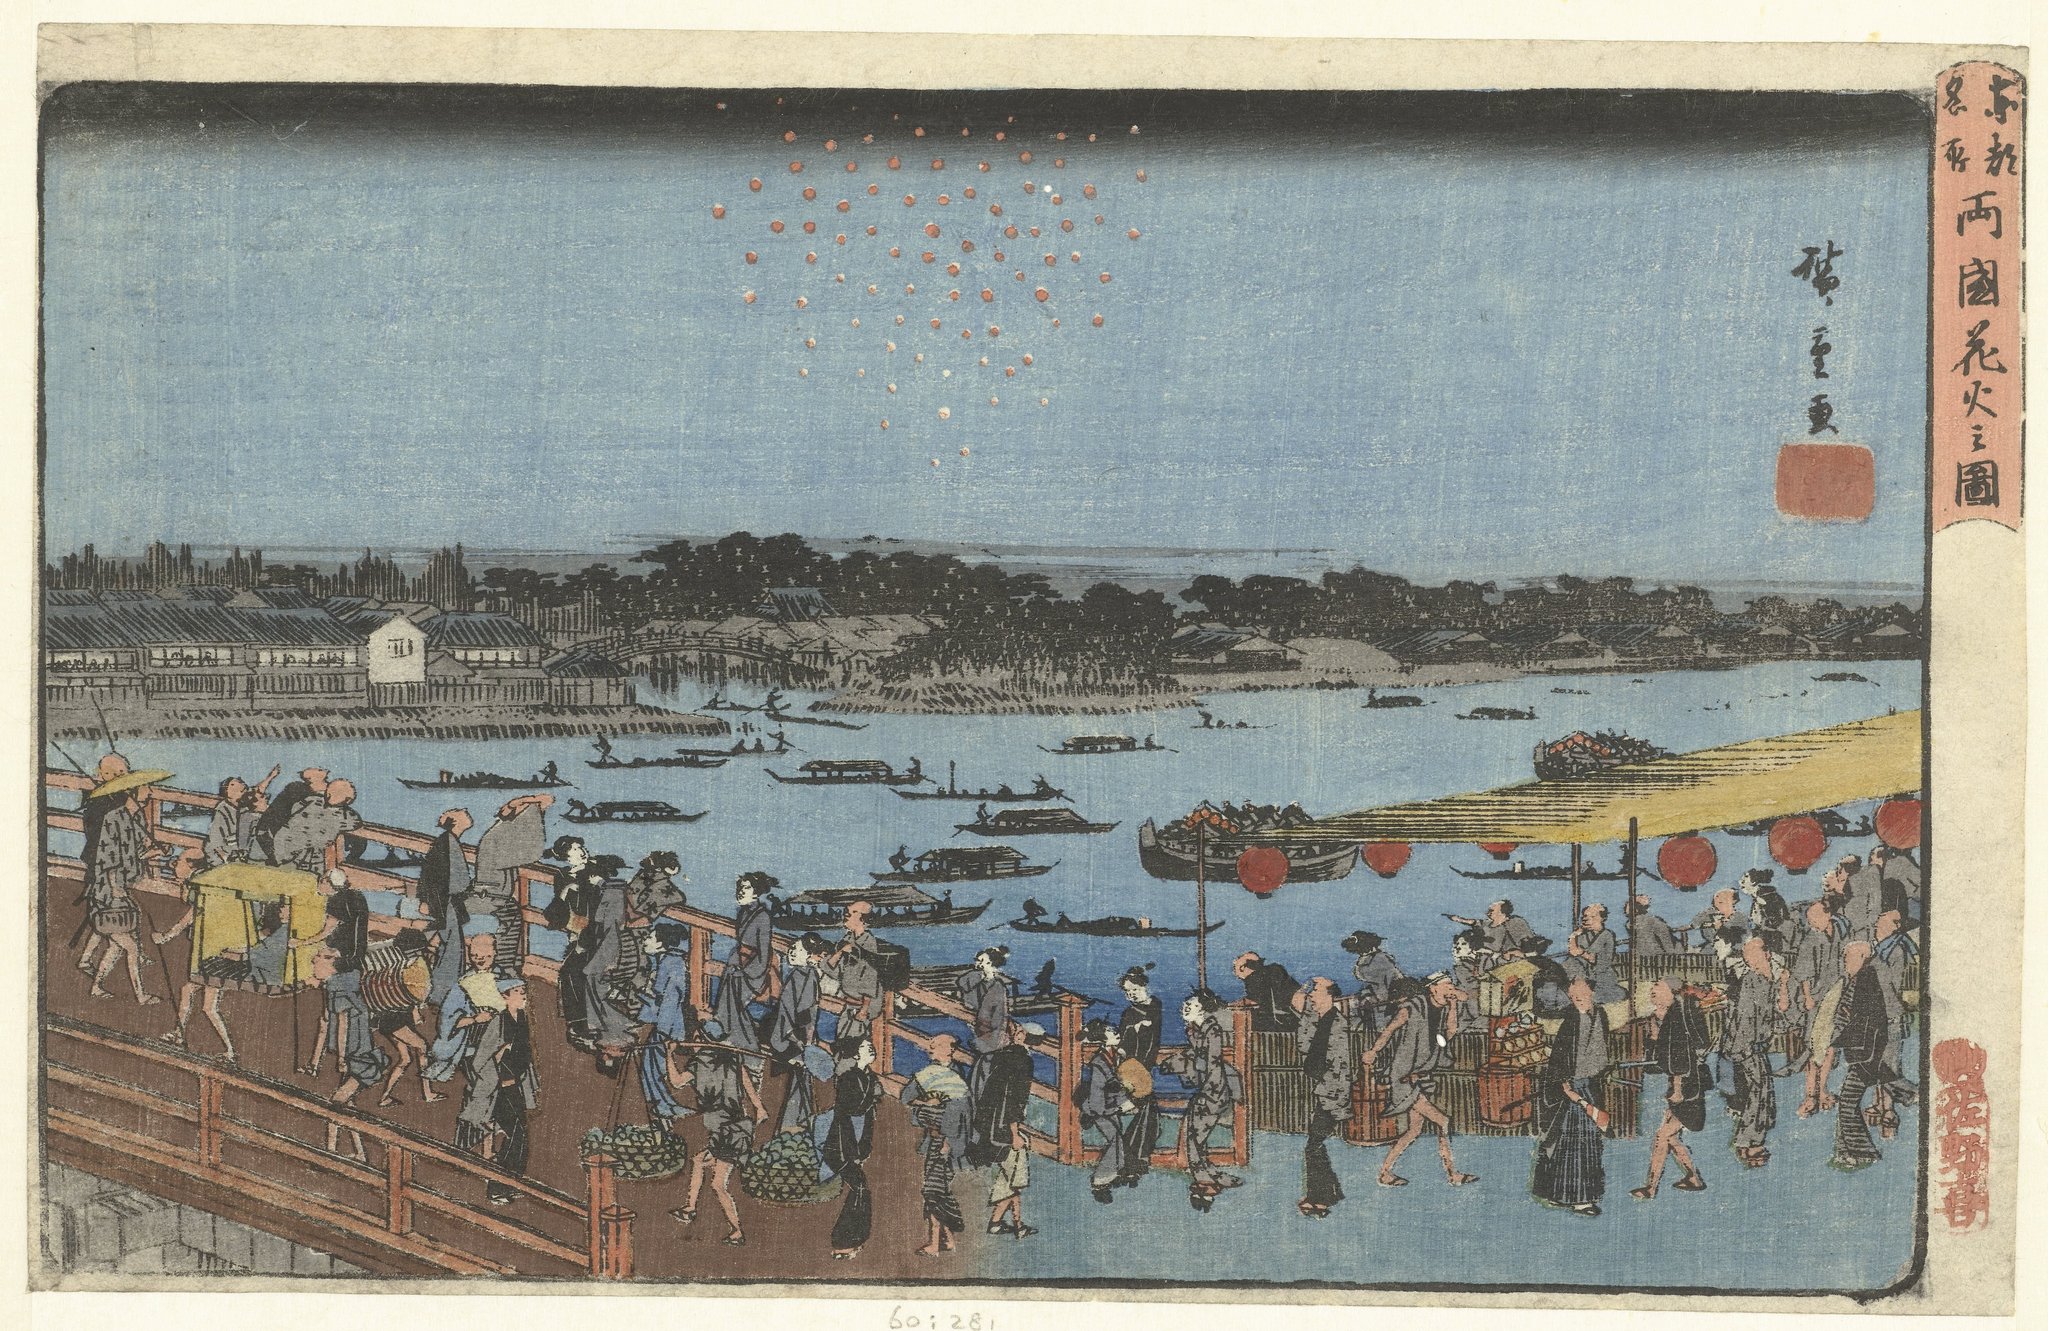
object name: print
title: Beroemde plaatsen in de Oostelijke hoofdstad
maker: utagawa hiroshige (i)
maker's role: draughtsman, print maker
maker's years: 1797-1858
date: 1835-1840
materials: paper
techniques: woodcut, nishiki e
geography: tokyo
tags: bonfire, fire-works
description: Mensen op de Ryogoku brug en bij kraampjes op de oever van de druk bevaren rivier de Sumida, kijkend naar vuurwerk; bij avond.